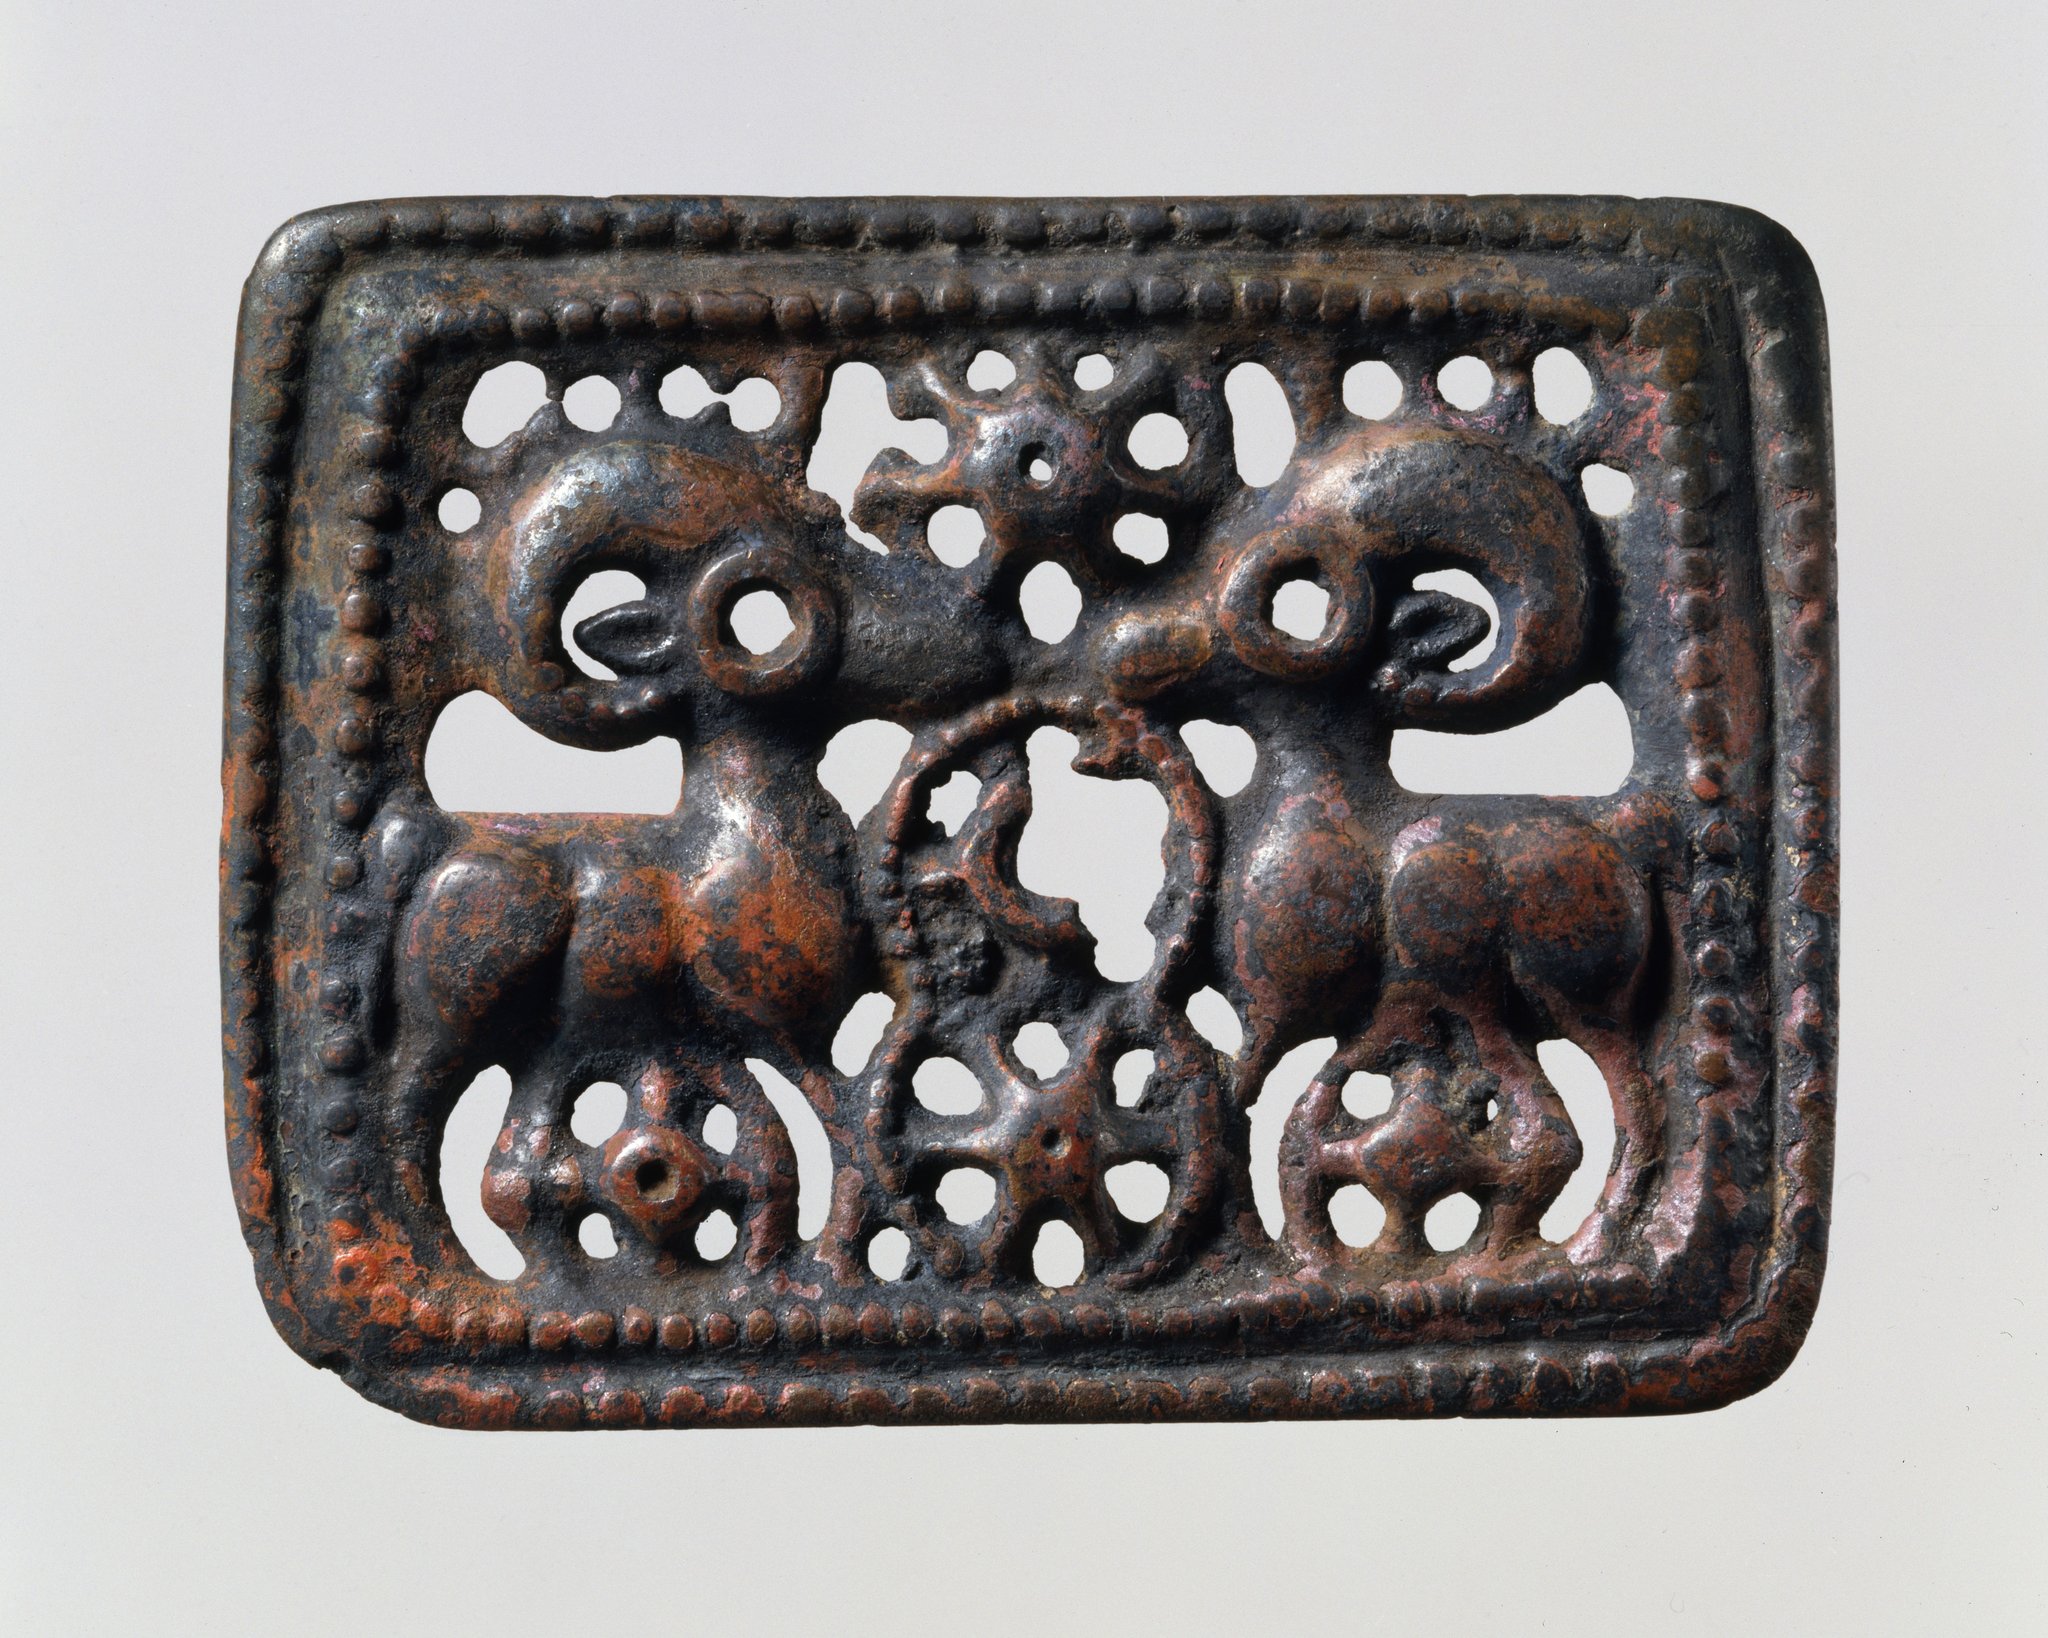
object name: belt plaque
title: Belt Plaque with Confronted Rams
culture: north chinese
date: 1-200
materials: bronze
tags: rams